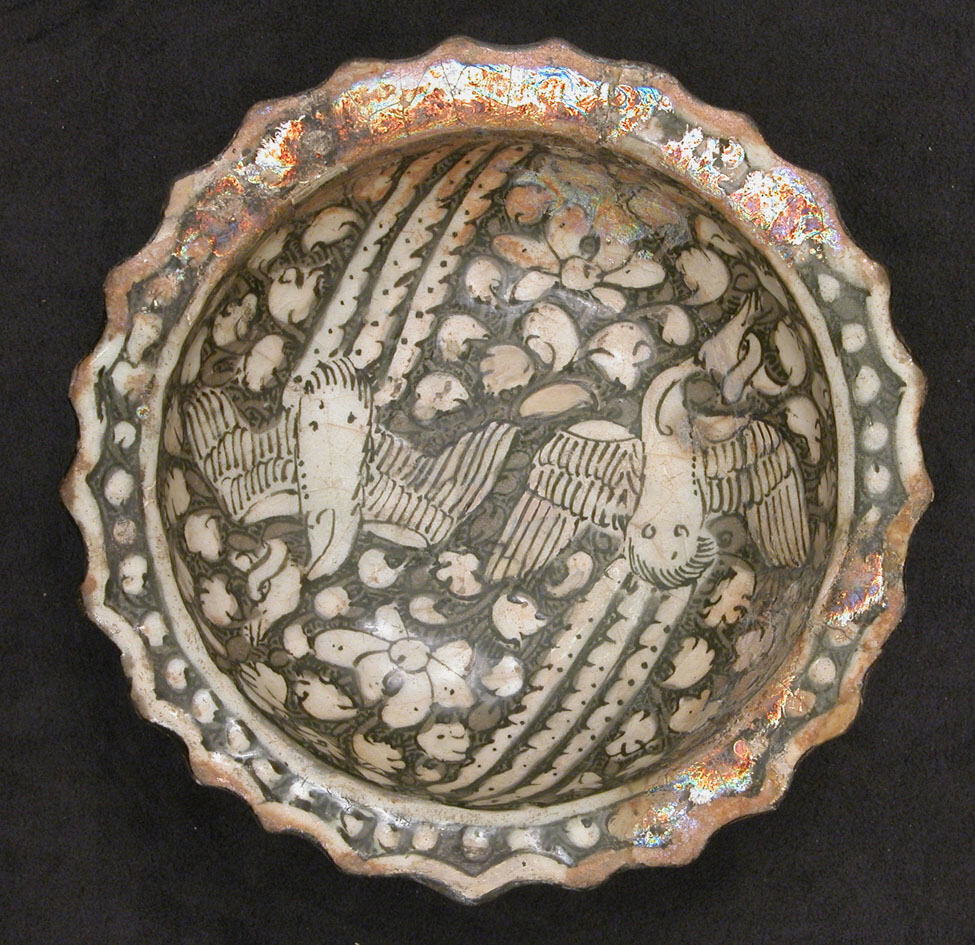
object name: dish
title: Plate with Phoenixes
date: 1301-1350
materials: glaze, stonepaste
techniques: painting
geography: iran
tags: phoenix